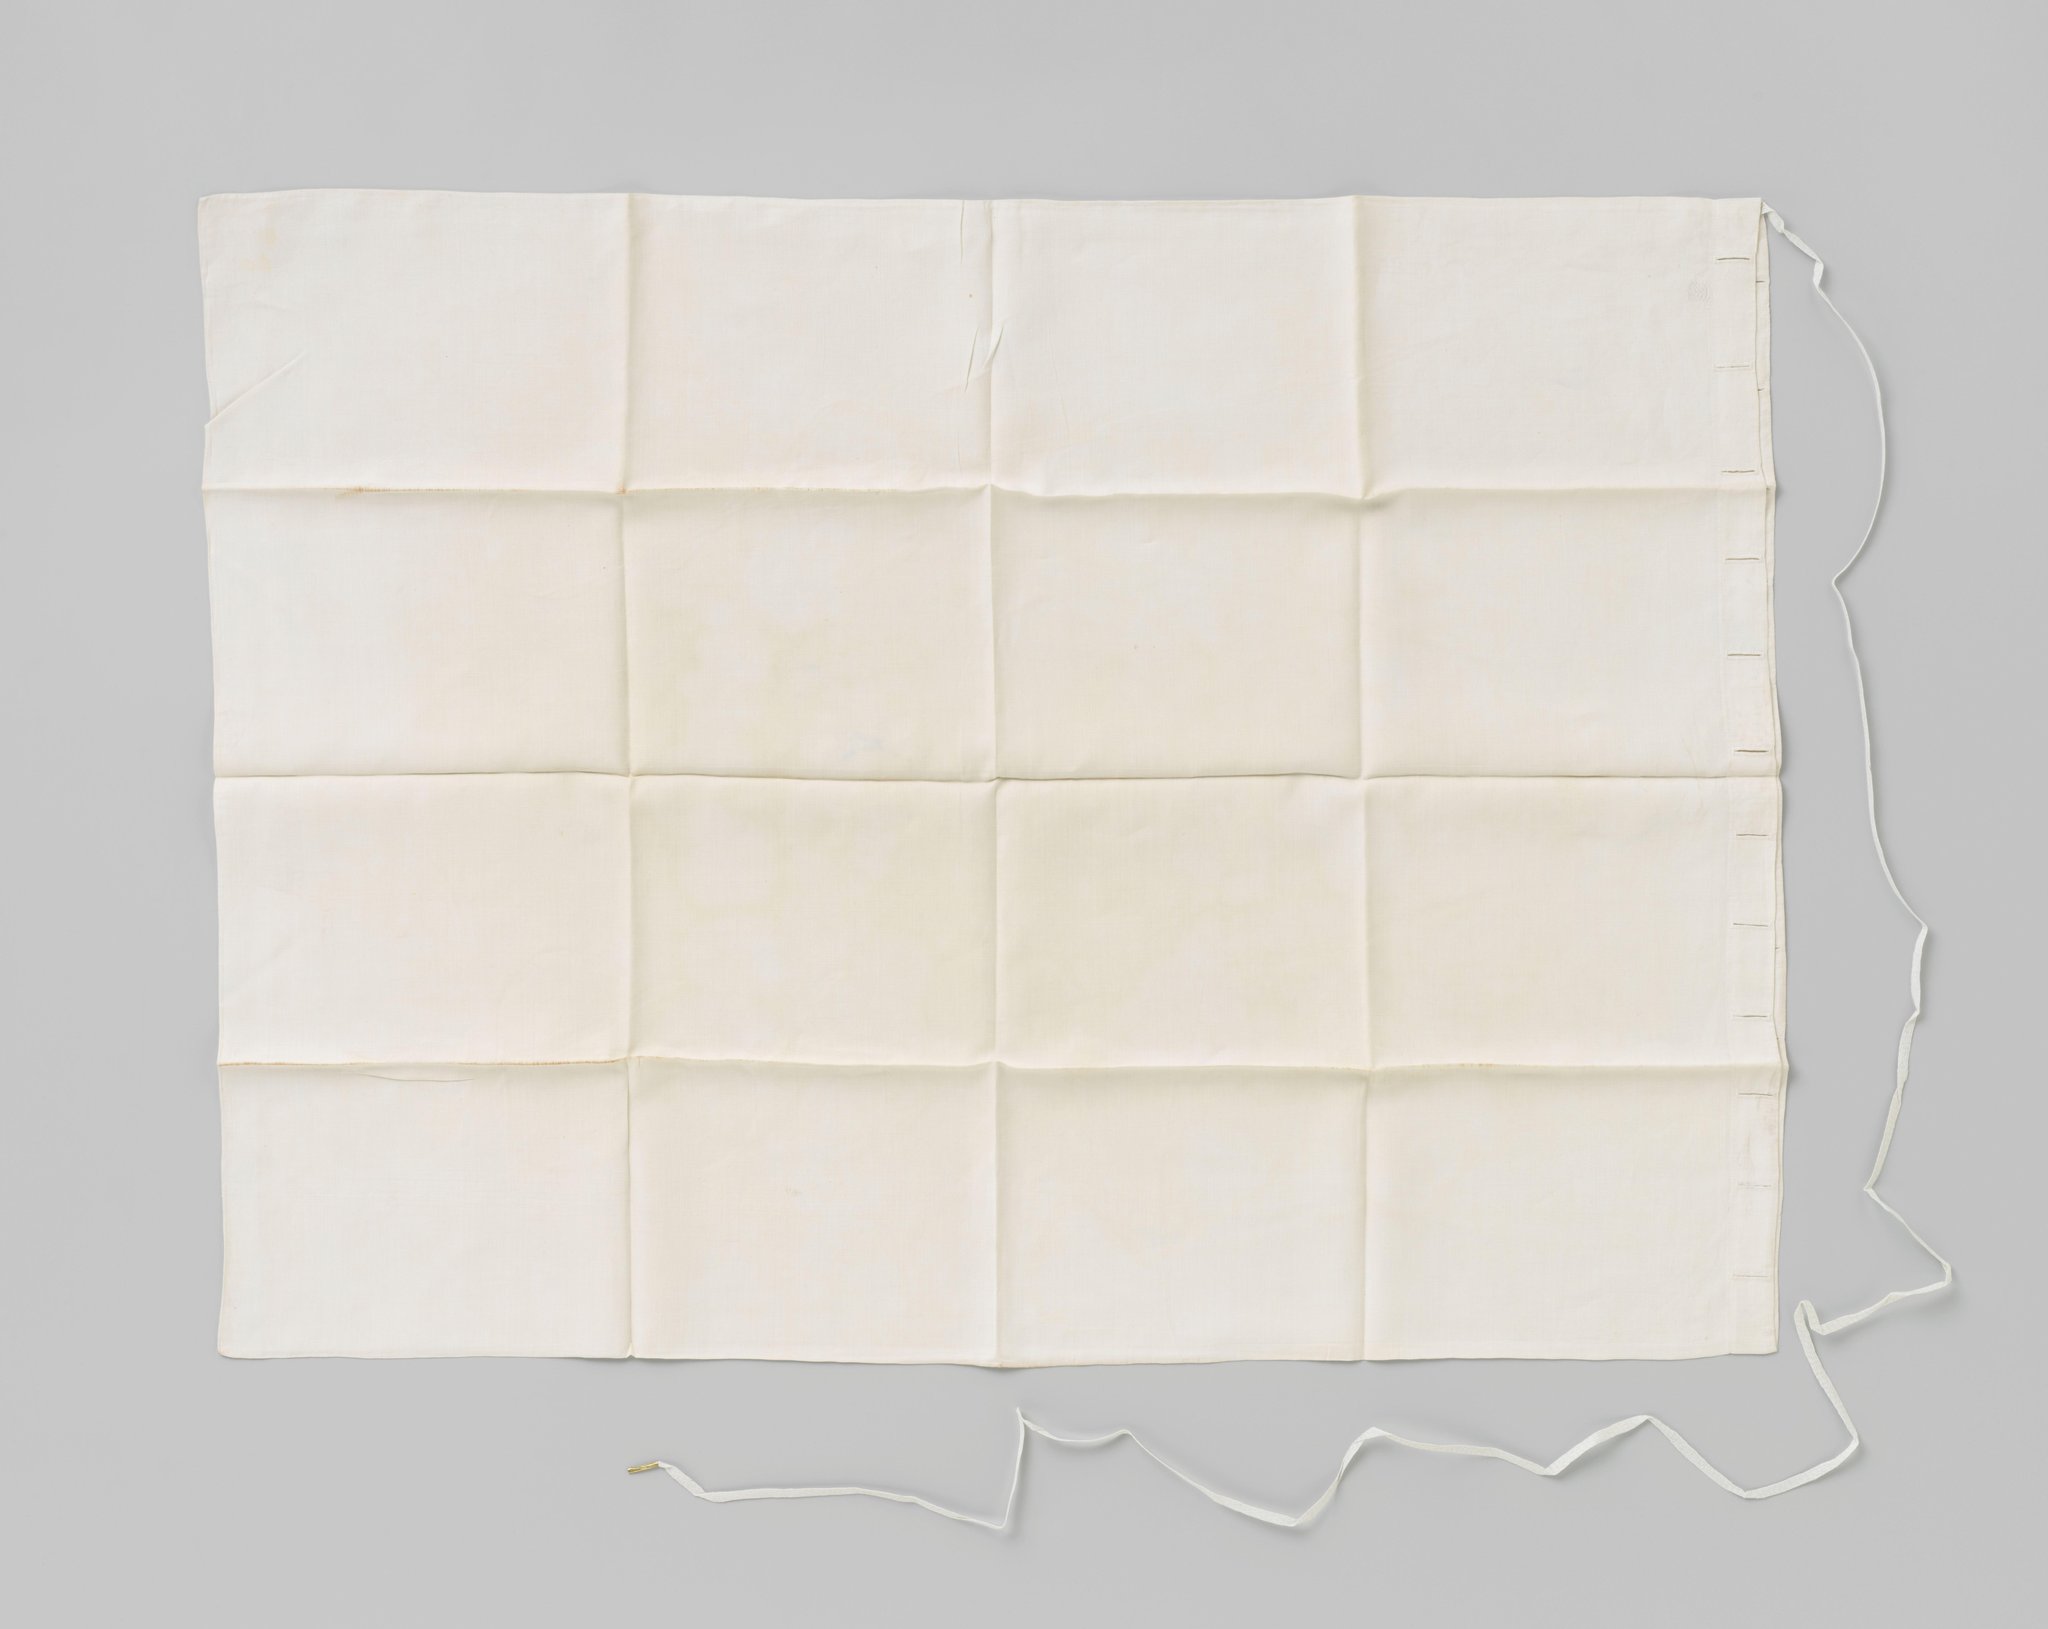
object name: sloop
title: Sloop van wit linnen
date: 1825-1875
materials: linen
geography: northern netherlands